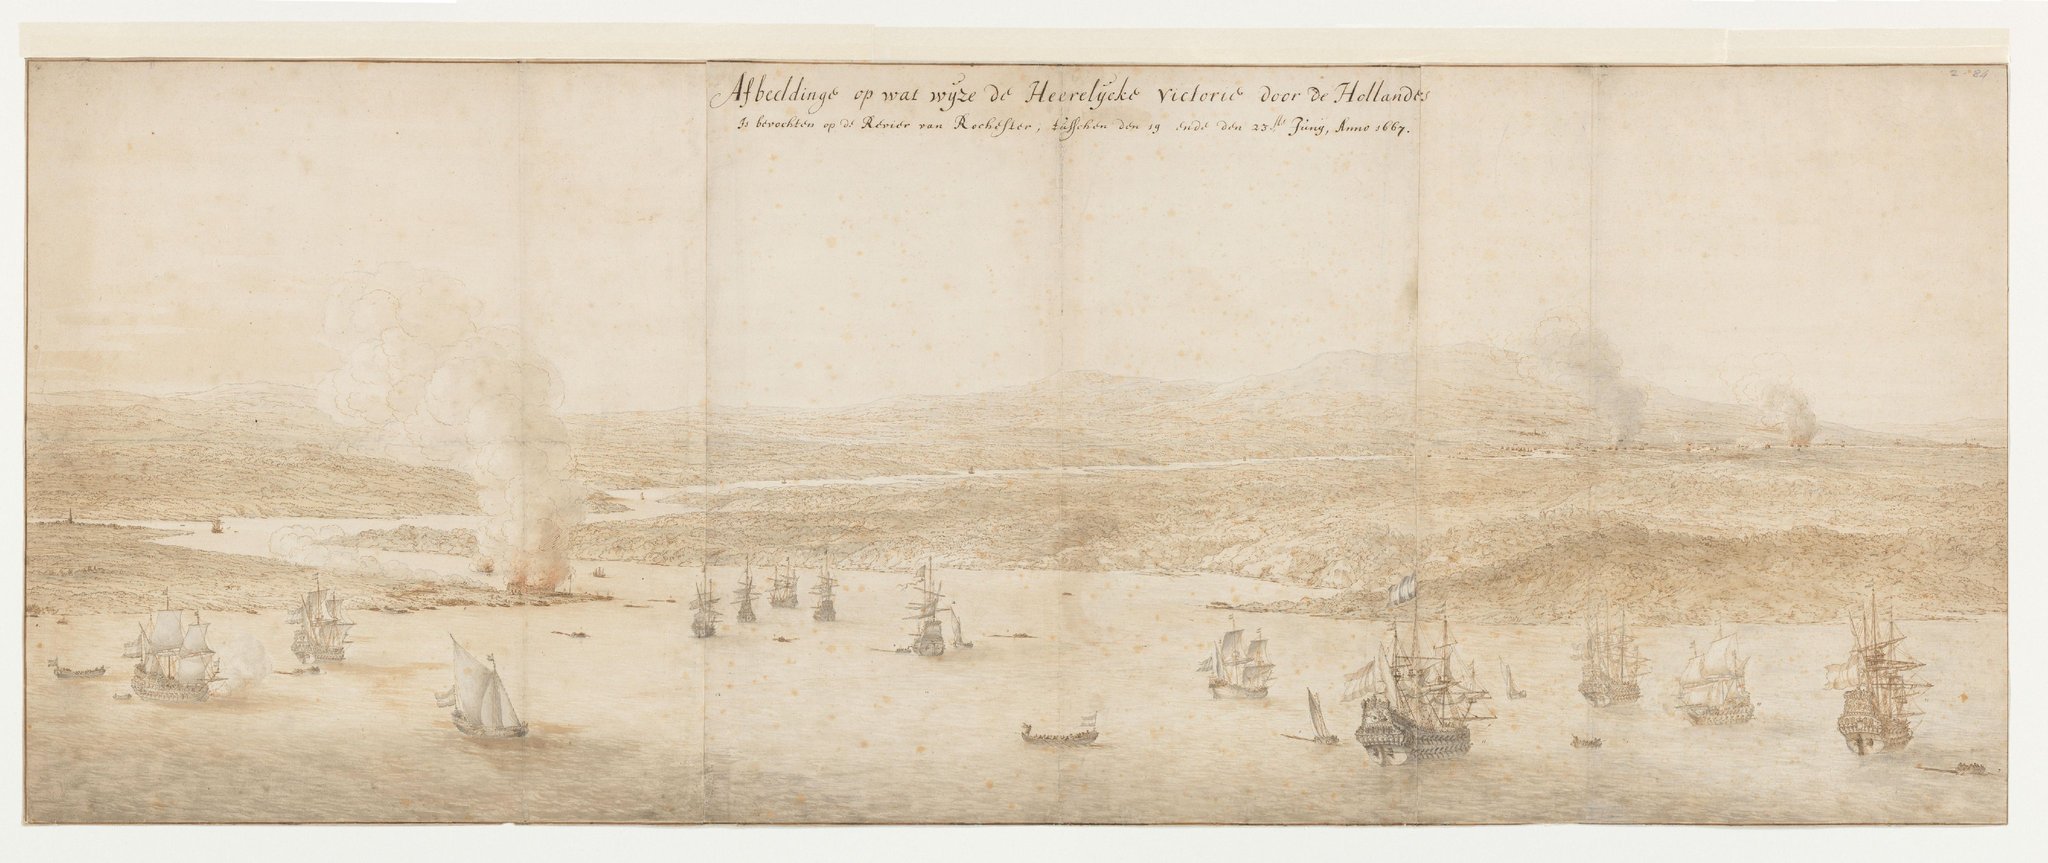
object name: drawing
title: Tocht naar Chatham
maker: Anonymous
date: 1667-1669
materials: chalk, ink, paper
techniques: brush, pen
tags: river, historical events and situations, raid on the medway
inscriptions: annotation: ‘Afbeeldinge op wat wijze de Heerlijcke victorie door de Hollandes is bevochten op de Revier van Rochester; tusschen den 19 ende den 23ste Junij, Anno 1667.’